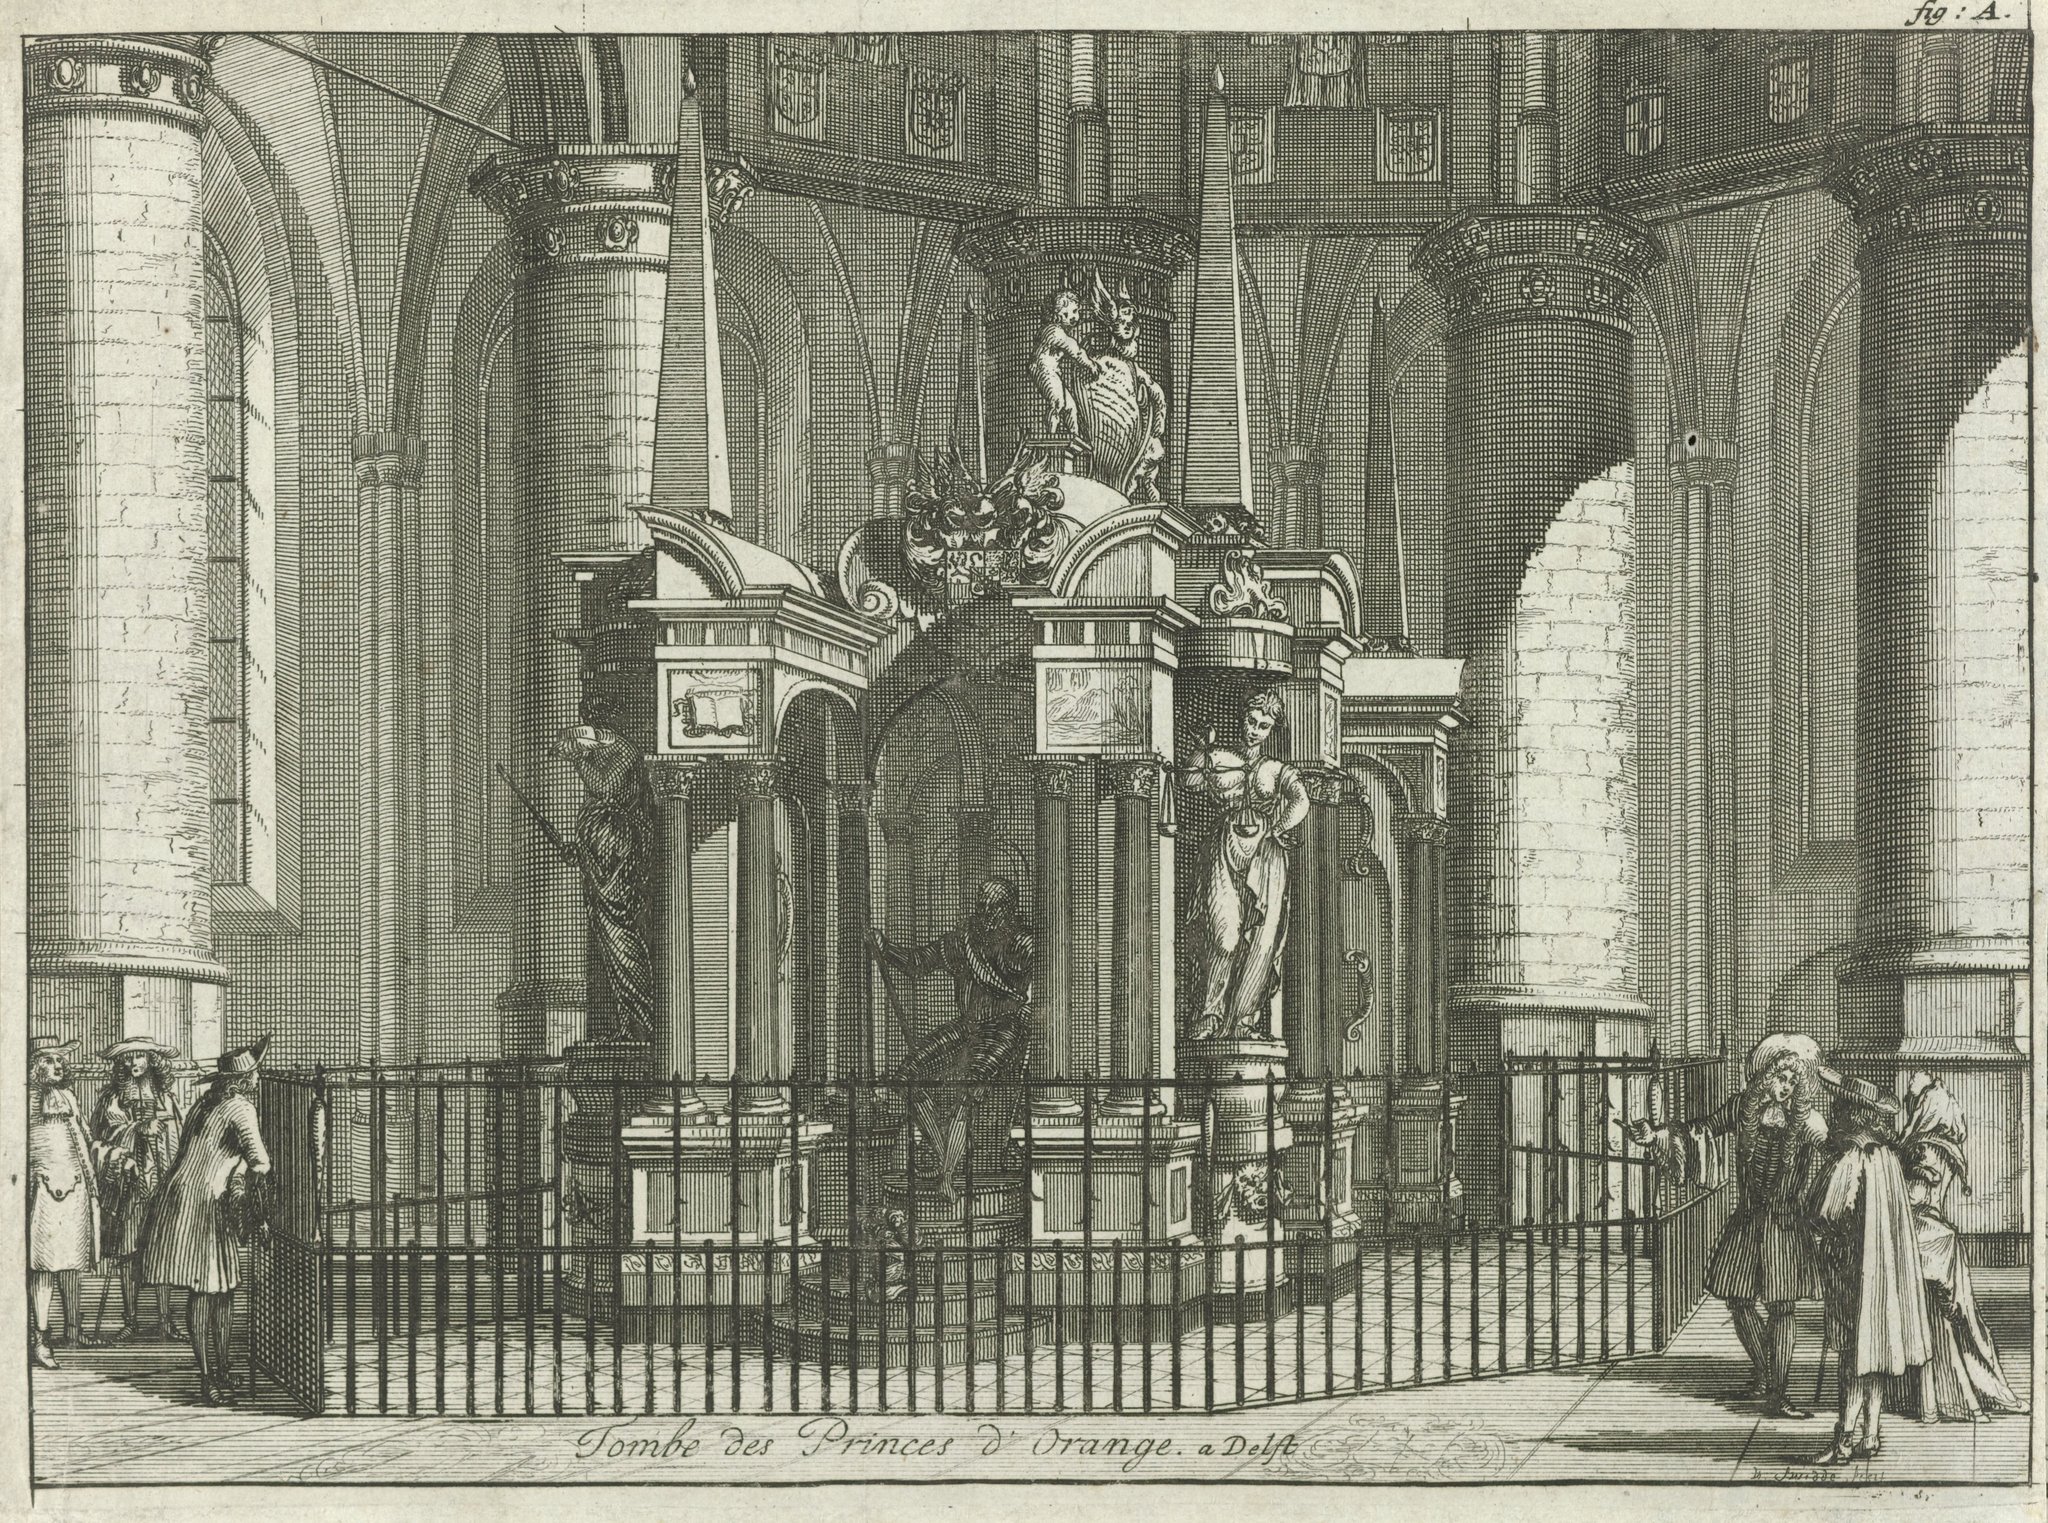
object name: print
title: Graftombe van Willem I, prins van Oranje, 1623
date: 1690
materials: paper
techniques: etching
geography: amsterdam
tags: delft, william i (prince of orange), historical persons, interior of church, grave-building, monumental tomb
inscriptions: collector's mark: Lugt 963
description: De hier vermelde titel verwijst naar de hoogst verkregen titel van de geportretteerde, niet per se naar de titel die de geportretteerde op deze voorstelling draagt. Prent uit: Nederlands helden-tooneel, vertoonende zeer cierlĳk in koper gesneeden alle de grafsteden. Amsterdam: Pieter Mortier, 1690.